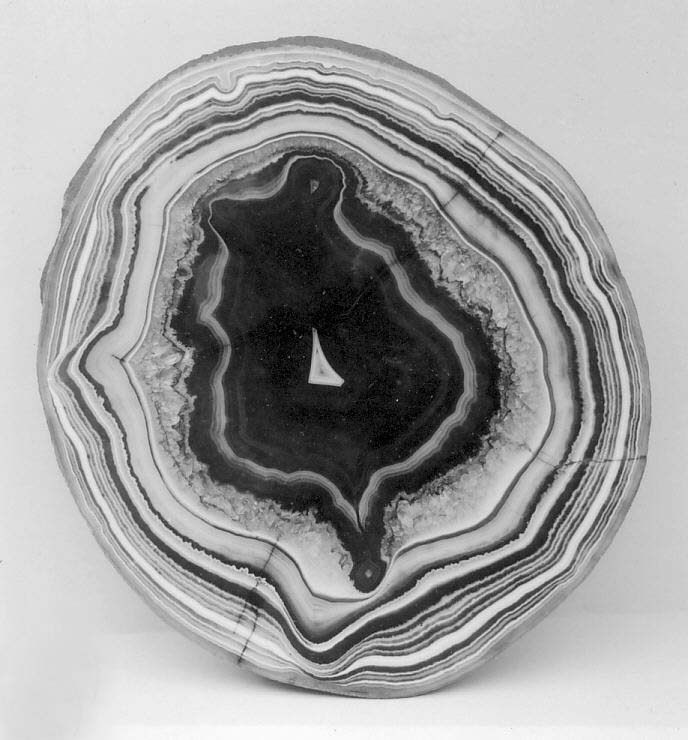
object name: stand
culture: japanese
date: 1760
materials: gemstone